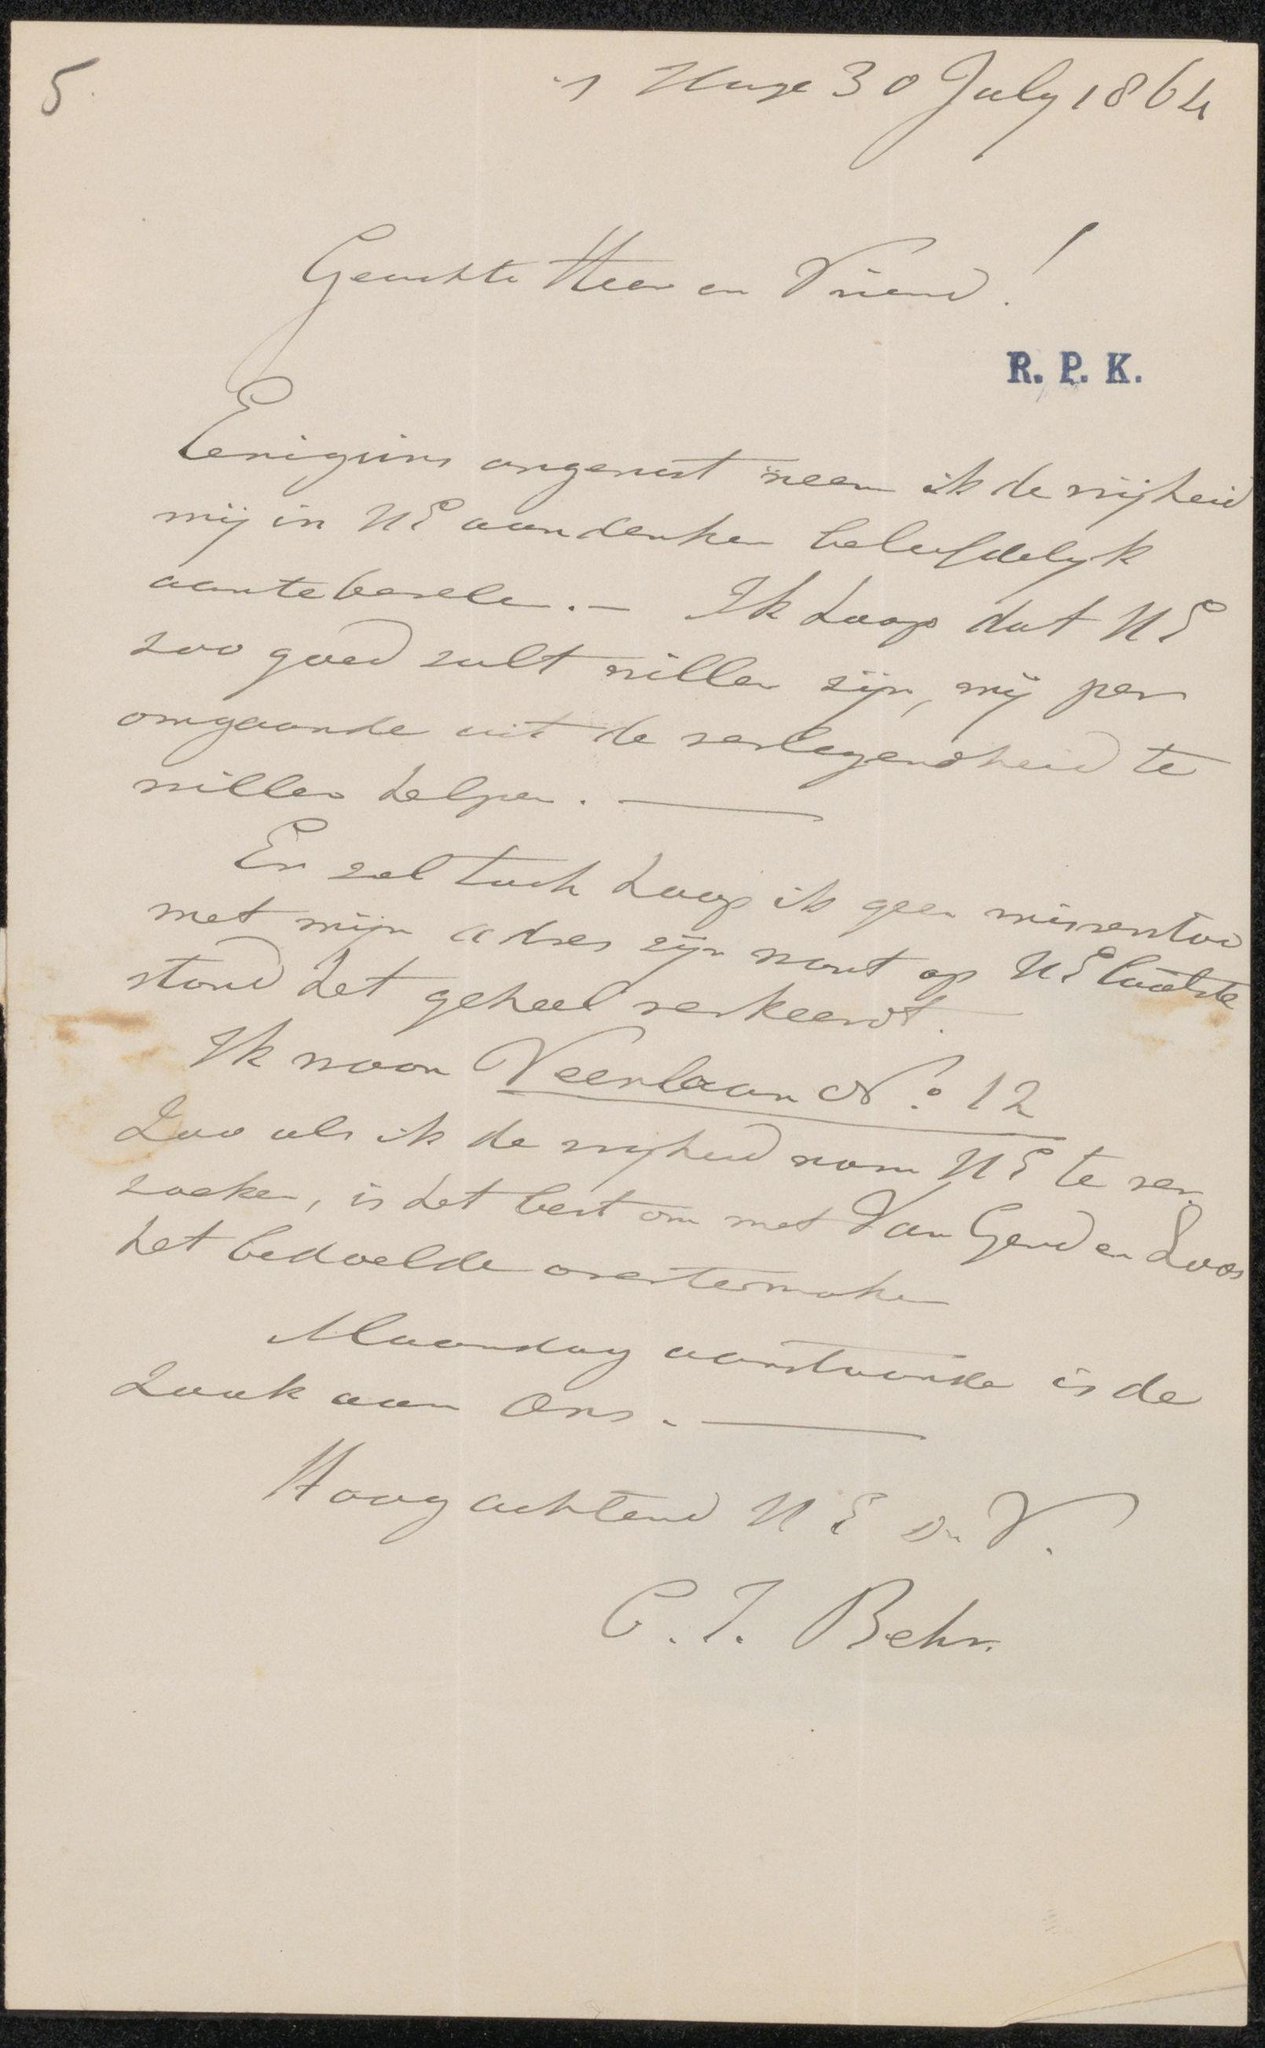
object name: letter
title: Brief aan Alberto Caramelli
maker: carel jacobus behr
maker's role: draughtsman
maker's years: 1812-1895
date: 1864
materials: ink, paper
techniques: pen, writing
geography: the hague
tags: utrecht, amsterdam, publisher, alberto caramelli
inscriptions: collector's mark: ‘RPK’ Lugt 2233